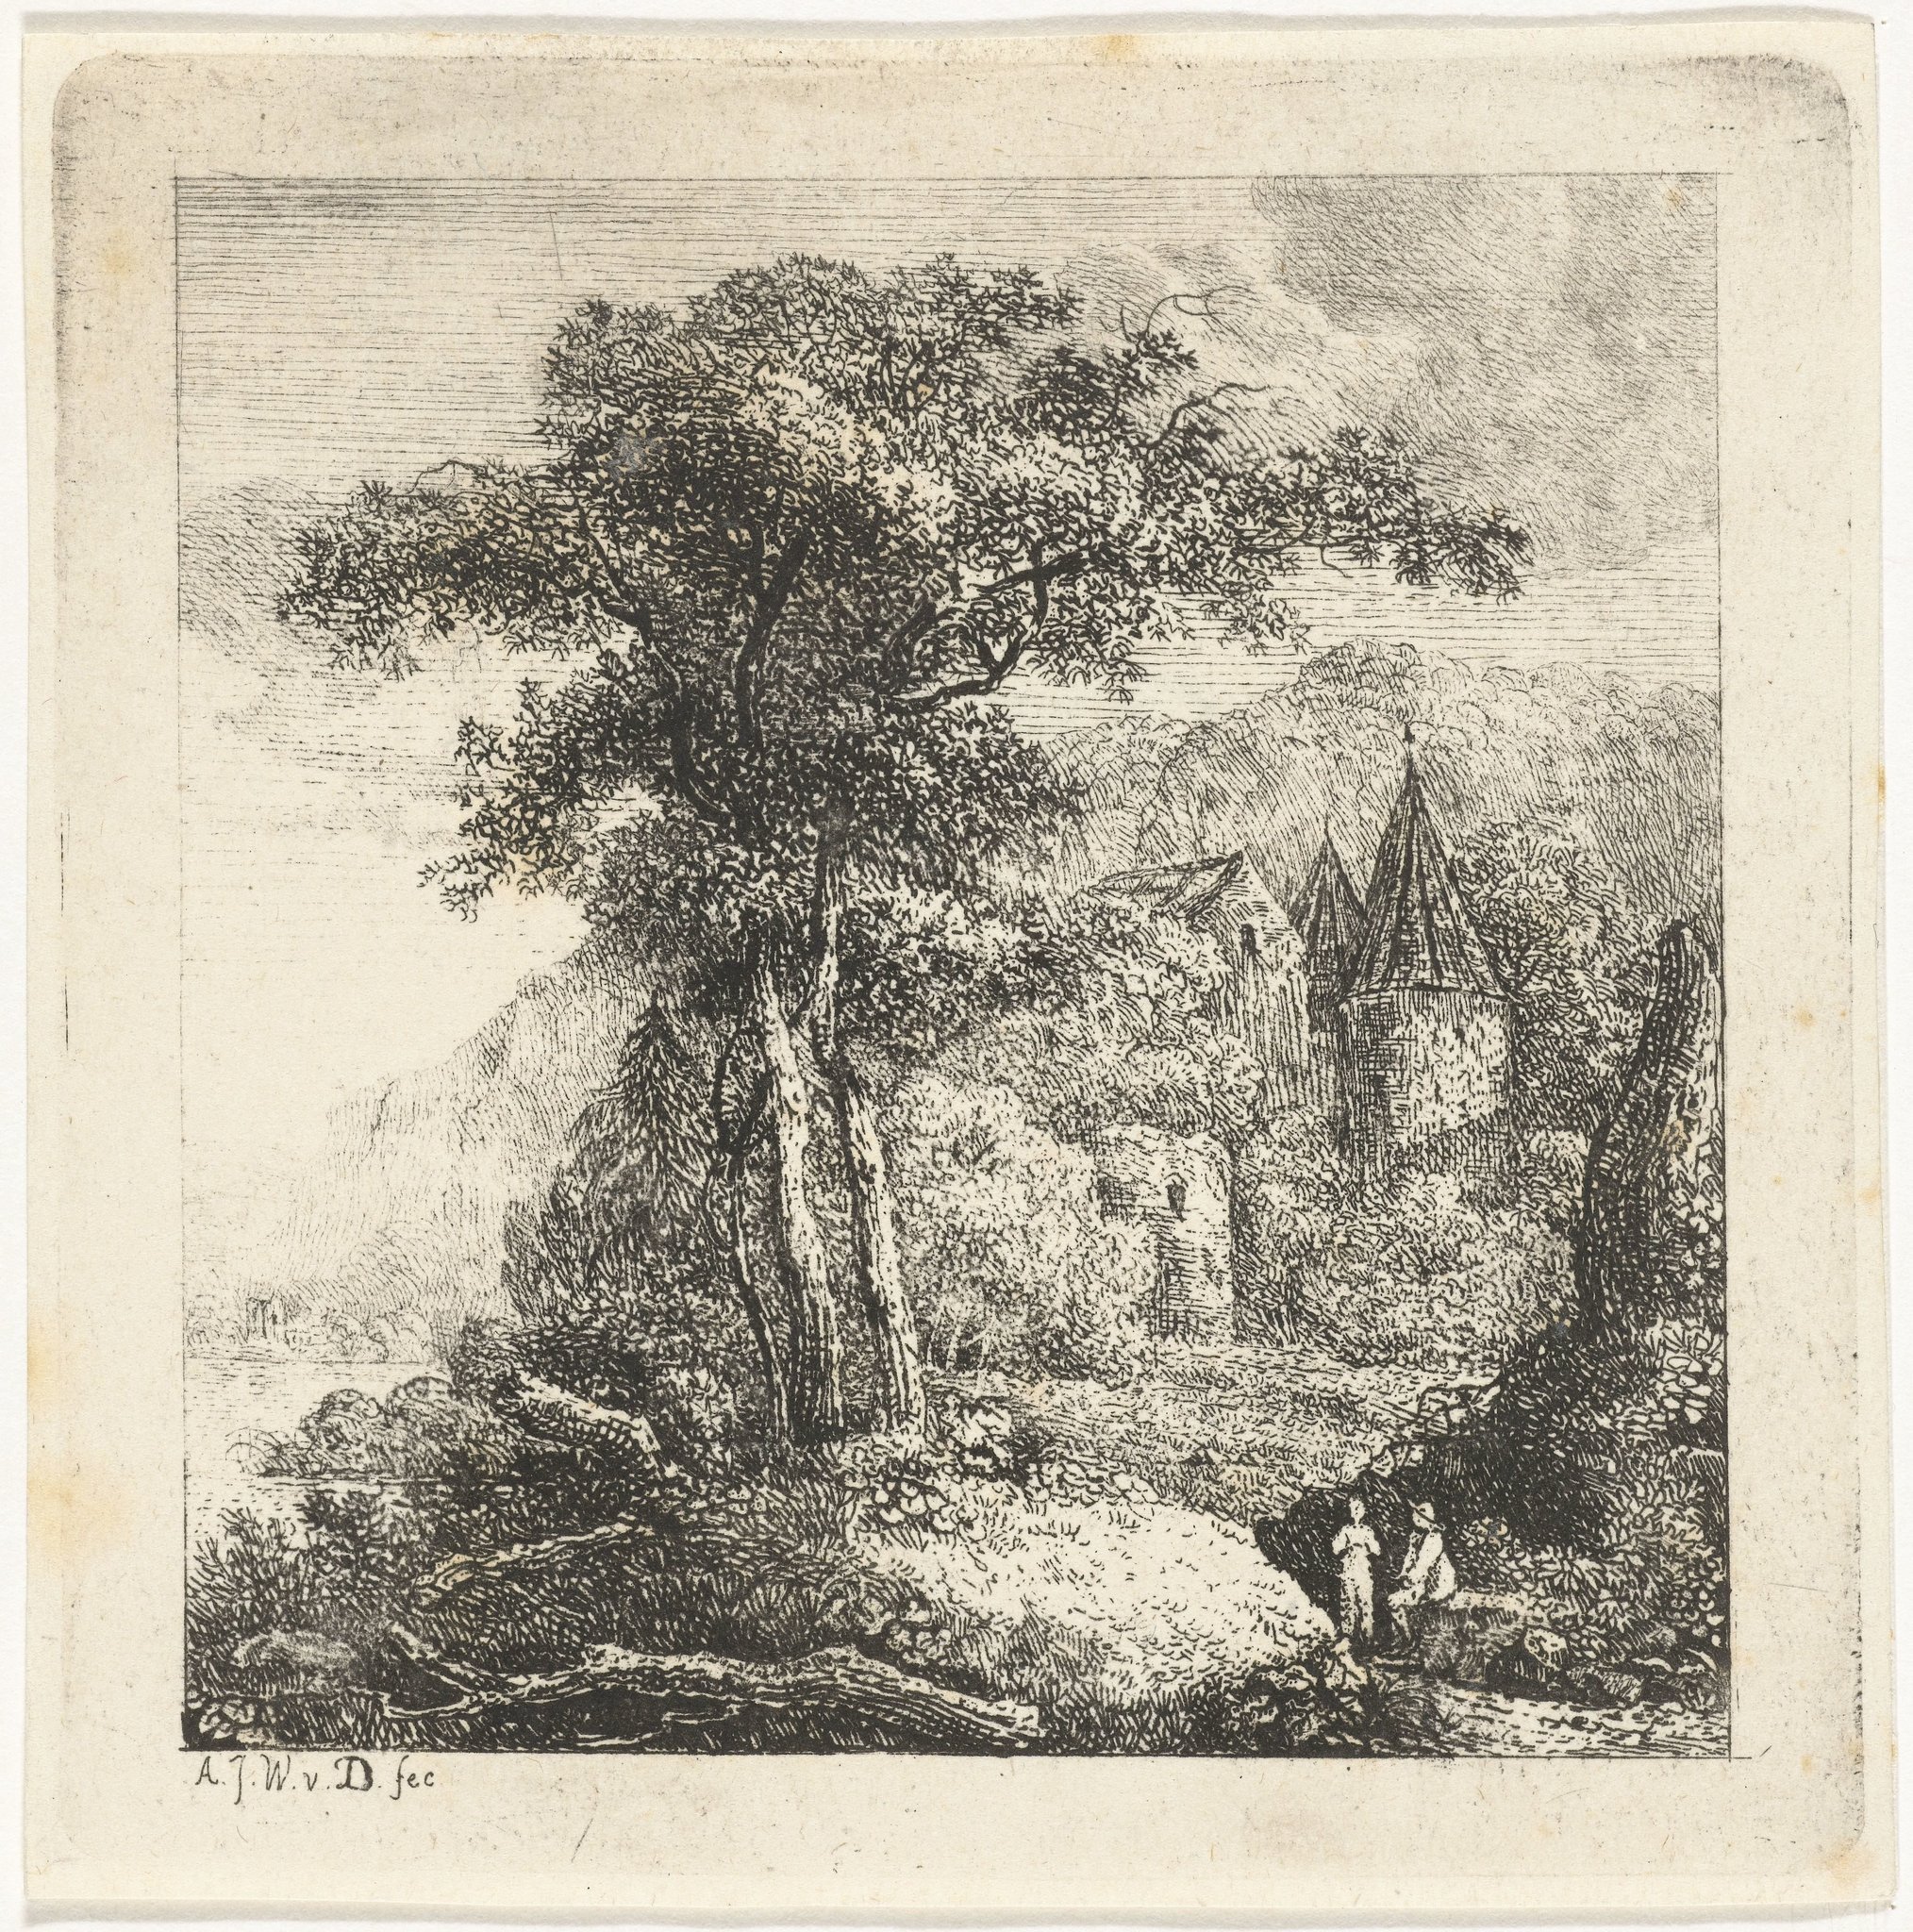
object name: print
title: Bergachtig landschap met bomen, kasteel en twee figuren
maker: adriaan jacob willem van dielen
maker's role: print maker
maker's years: 1772-1812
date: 1772-1812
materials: paper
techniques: etching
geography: netherlands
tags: landscape with tower or castle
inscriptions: collector's mark: Lugt 2760, collector's mark: Lugt 2228